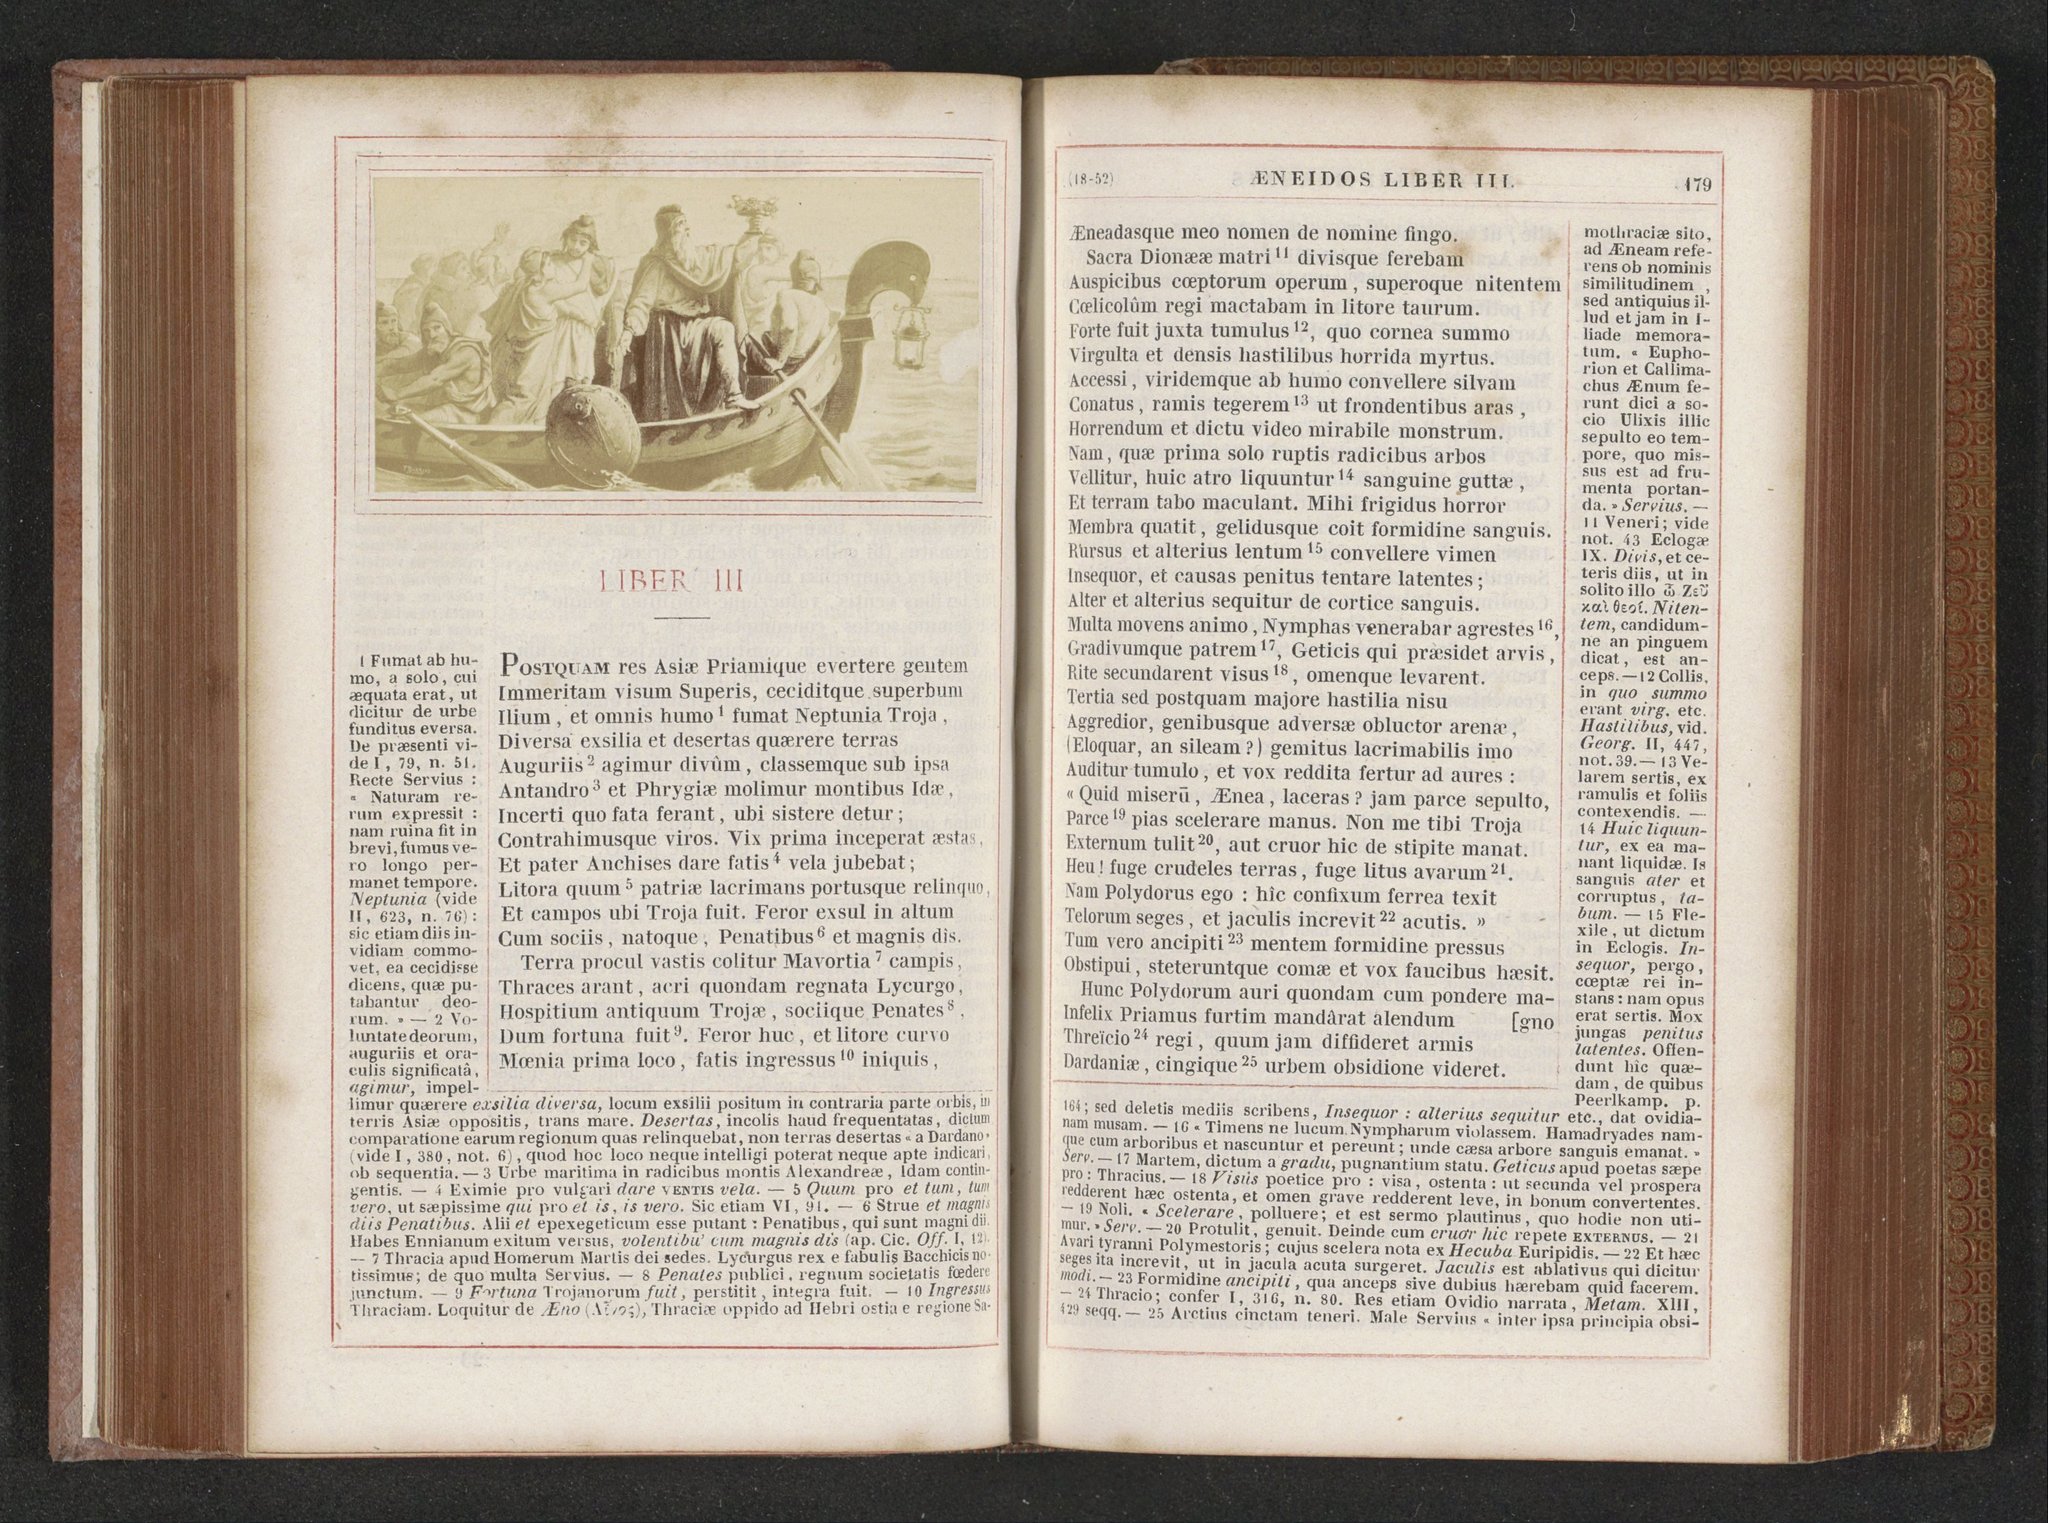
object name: photograph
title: Fotoreproductie van een schilderij, voorstellende Aeneas en Ascanius vluchten met een boot uit Troje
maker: Anonymous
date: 1850-1858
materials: photographic support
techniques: albumen print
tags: the fleet of aeneas sets out